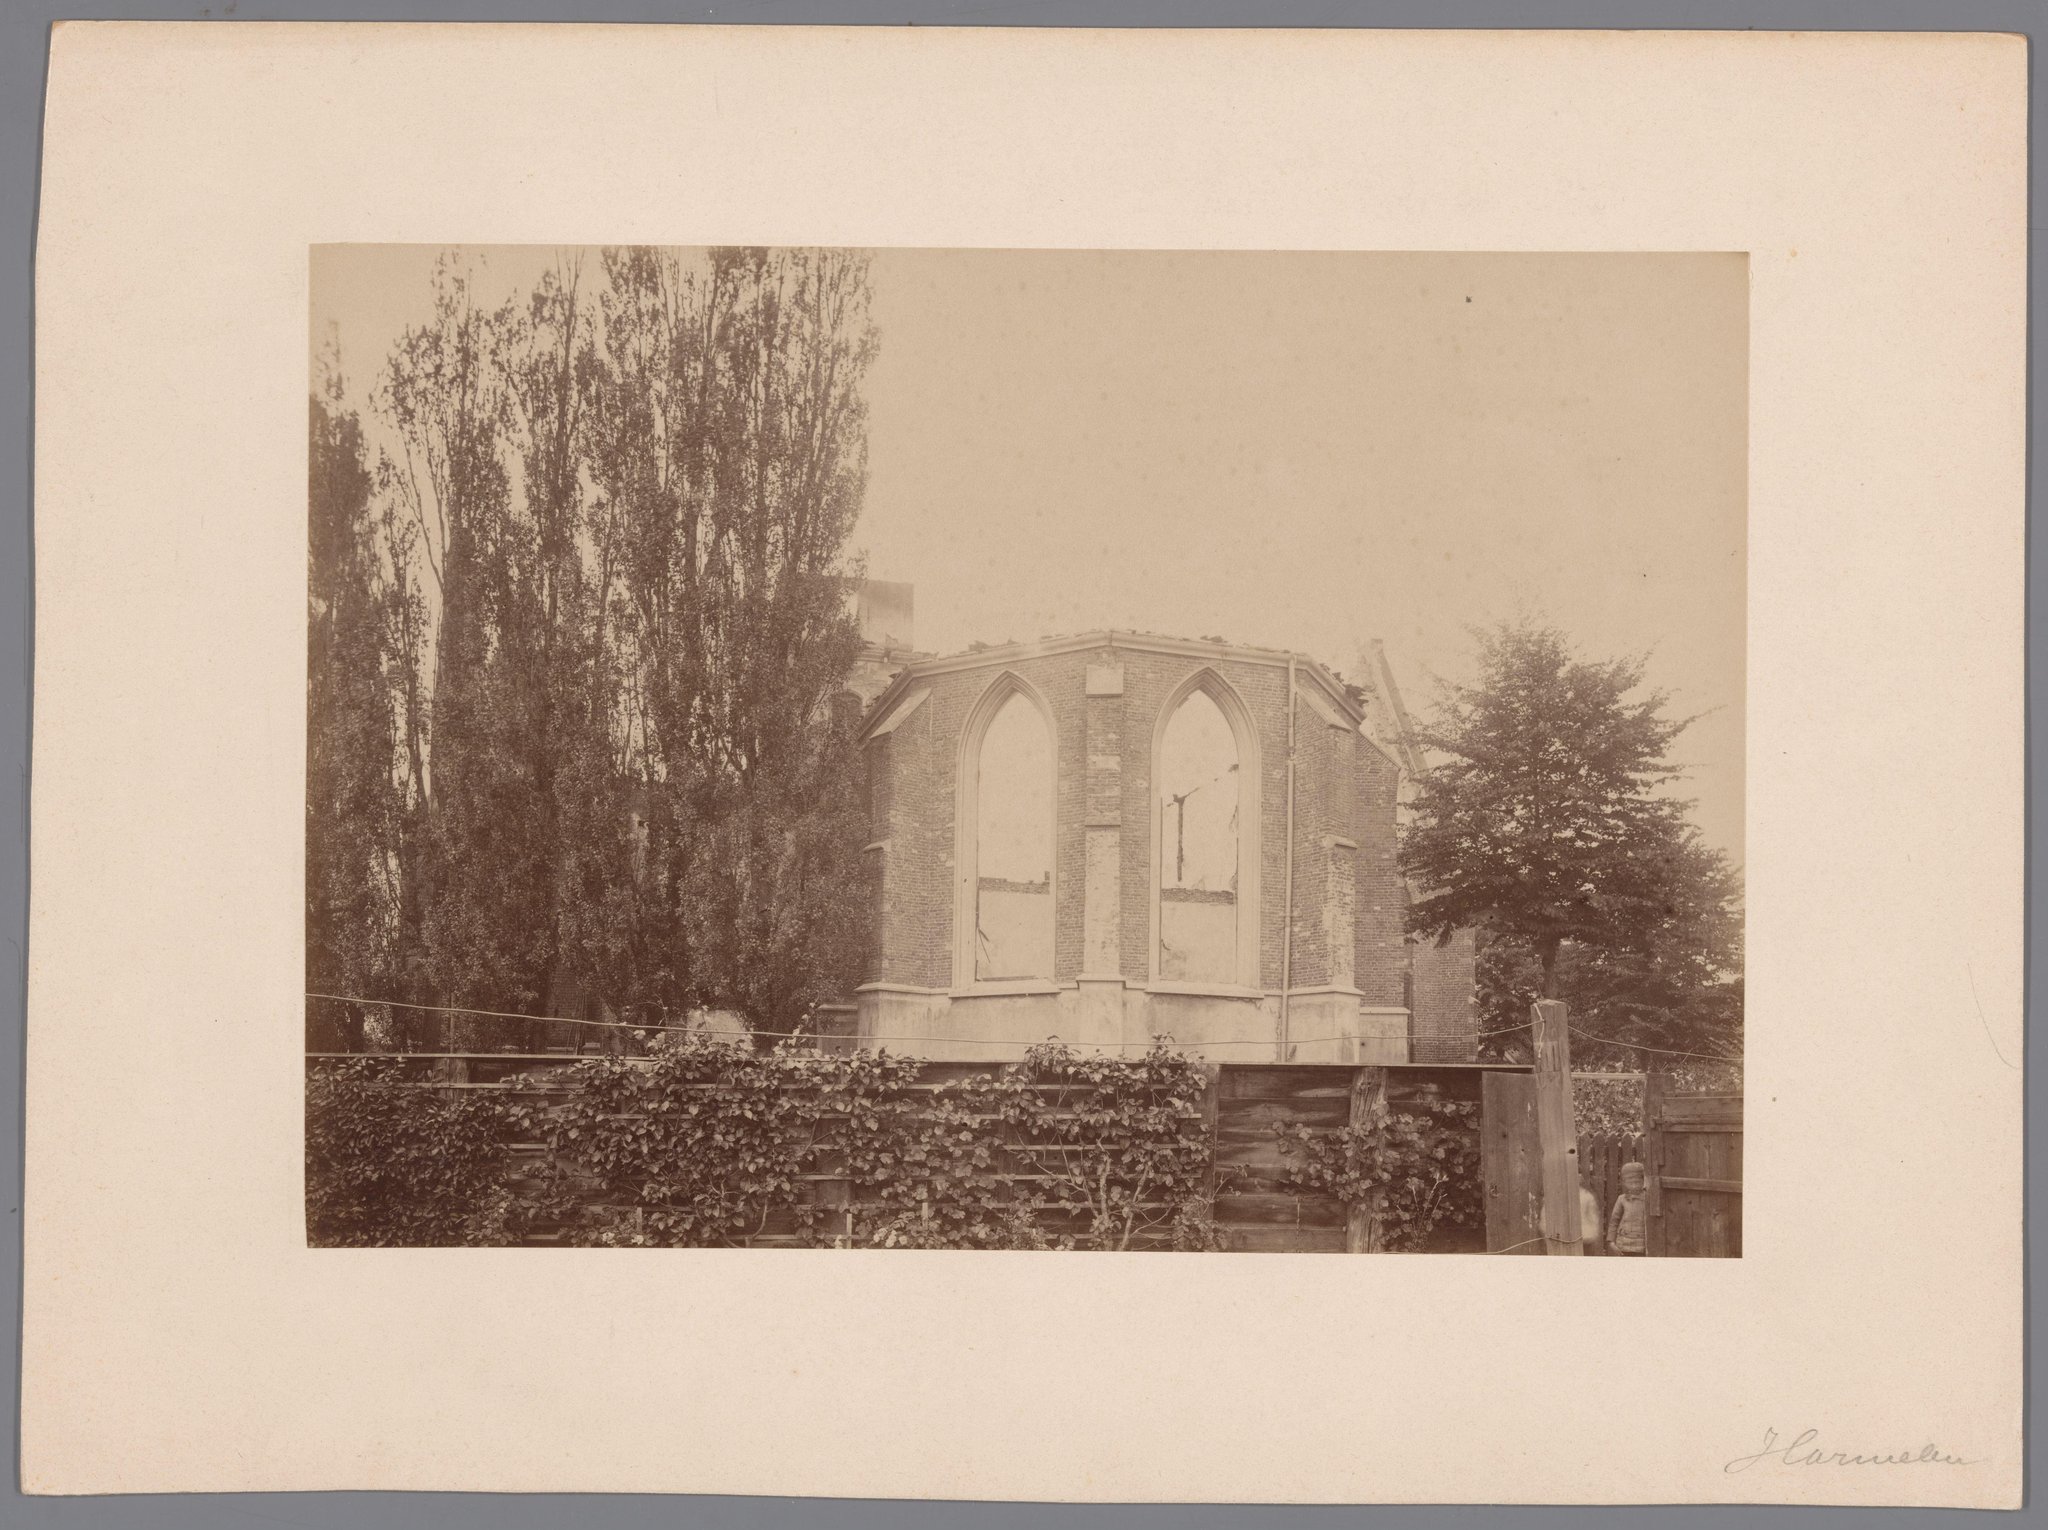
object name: photograph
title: Koor van de afgebrande Hervormde Kerk te Harmelen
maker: anoniem (monumentenzorg)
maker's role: fotograaf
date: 1900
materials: cardboard, photographic support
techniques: albumen print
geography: harmelen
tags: parts of church exterior and annexes: choir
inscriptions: annotation: ‘Ned. Herv. kerk te Harmelen (U.)/ Na den brand in juni 1900’, annotation: ‘Harmelen’